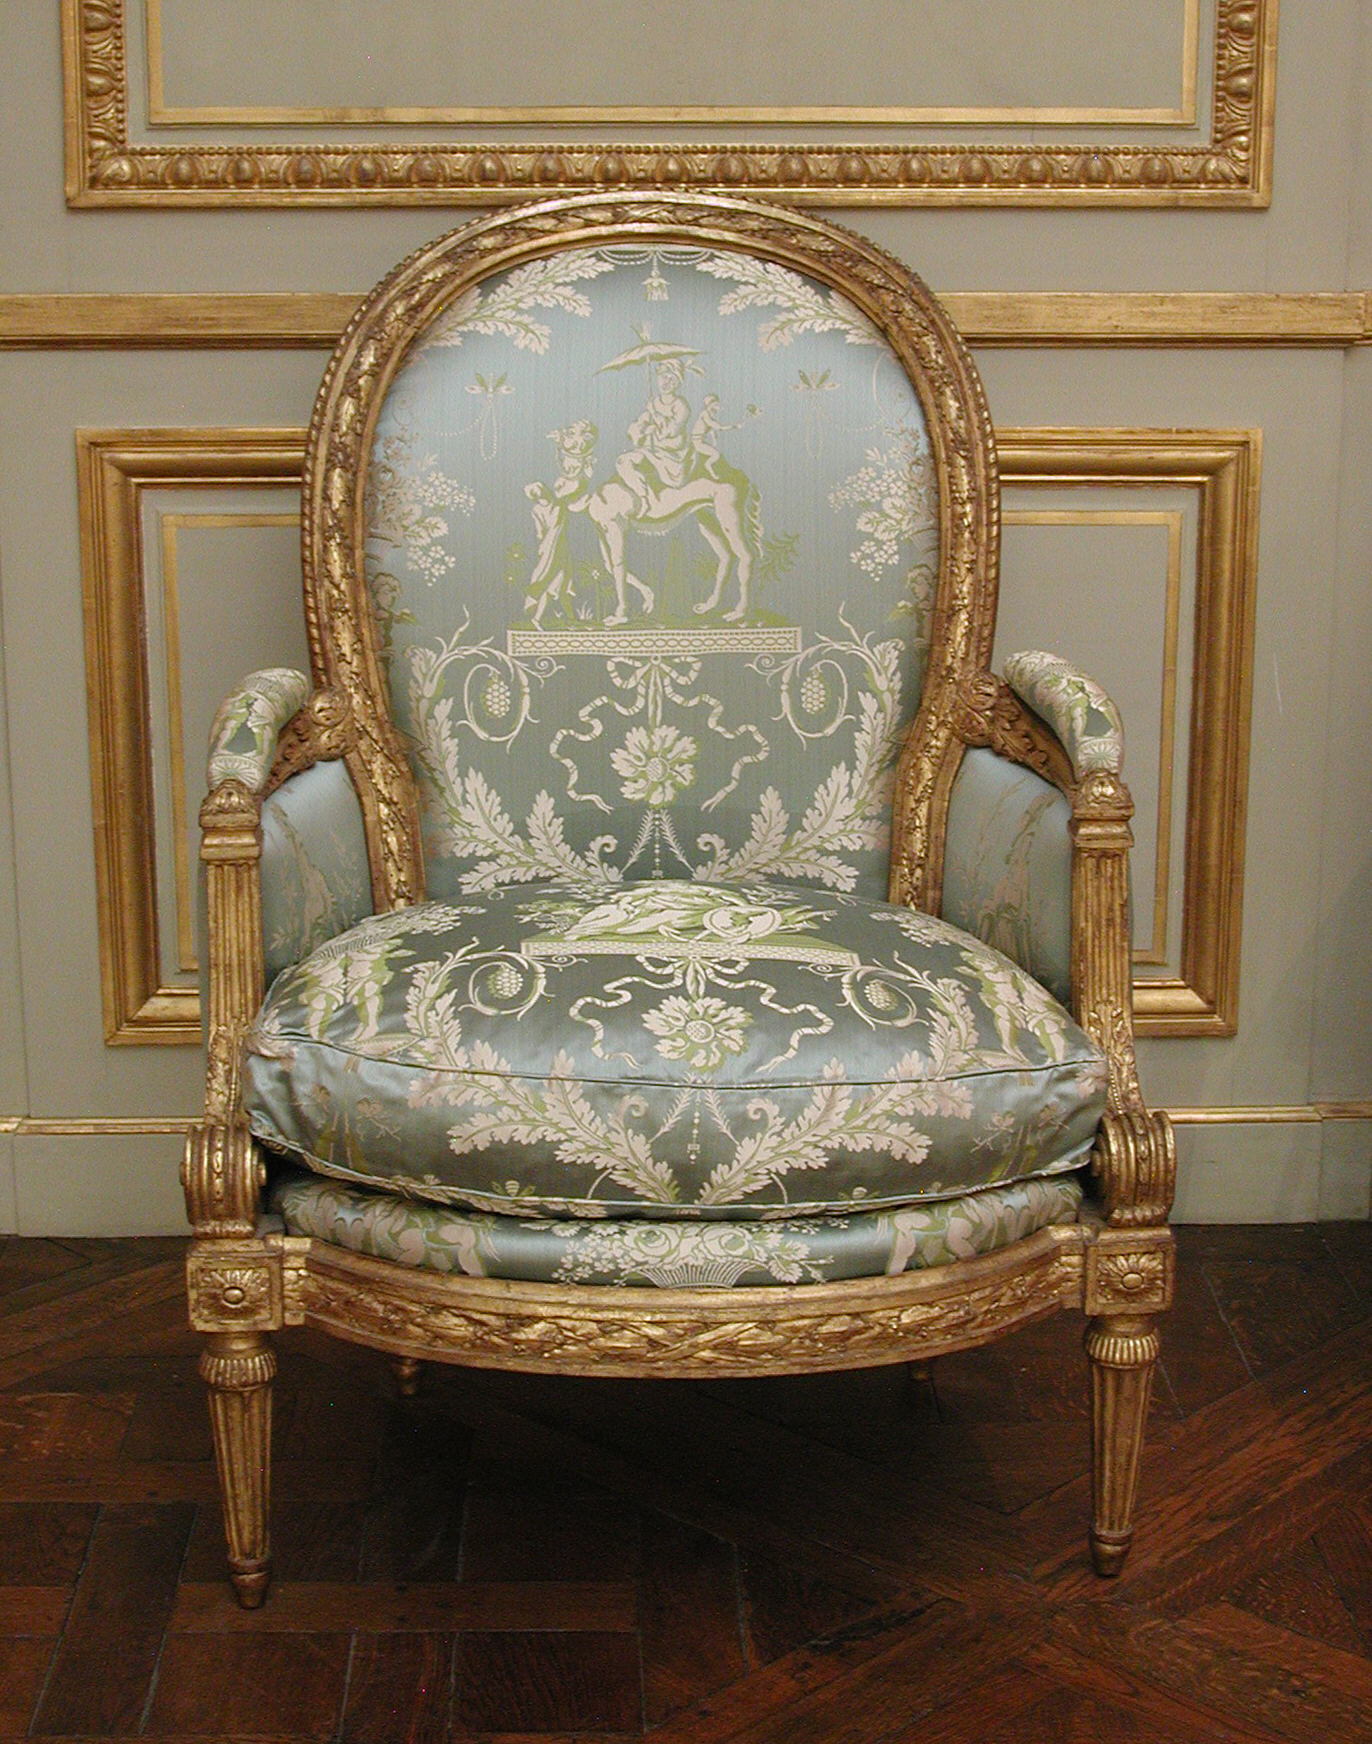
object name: armchair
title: Armchair (Bergère) (one of a pair) (part of a set)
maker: louis delanois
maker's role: maker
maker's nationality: french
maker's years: 1731-1792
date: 1770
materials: wood, silk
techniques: carving, damask, gilding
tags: camels,flowers